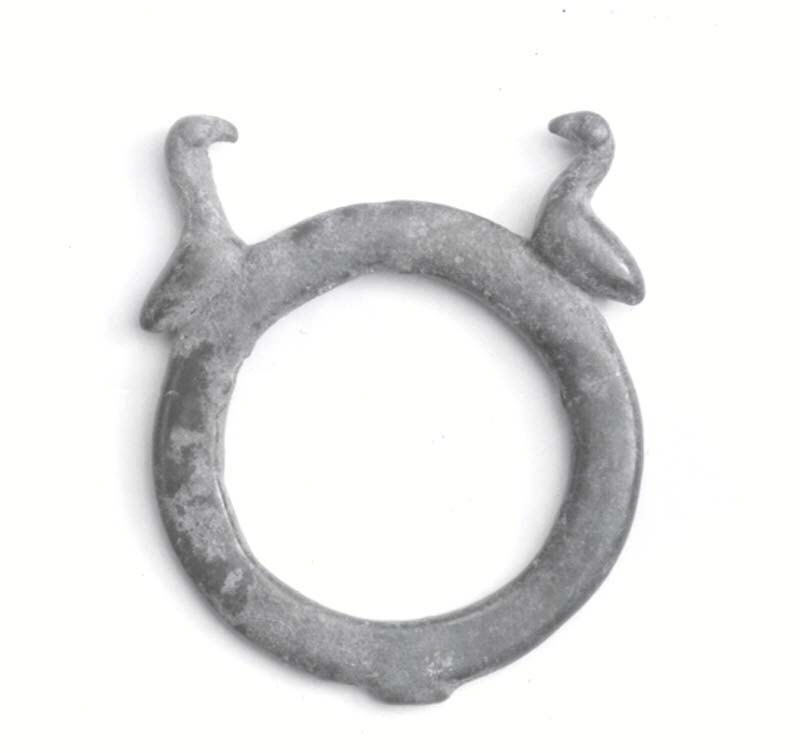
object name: harness ring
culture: iranian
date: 800-601 BCE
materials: bronze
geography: iran, probably from luristan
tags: birds